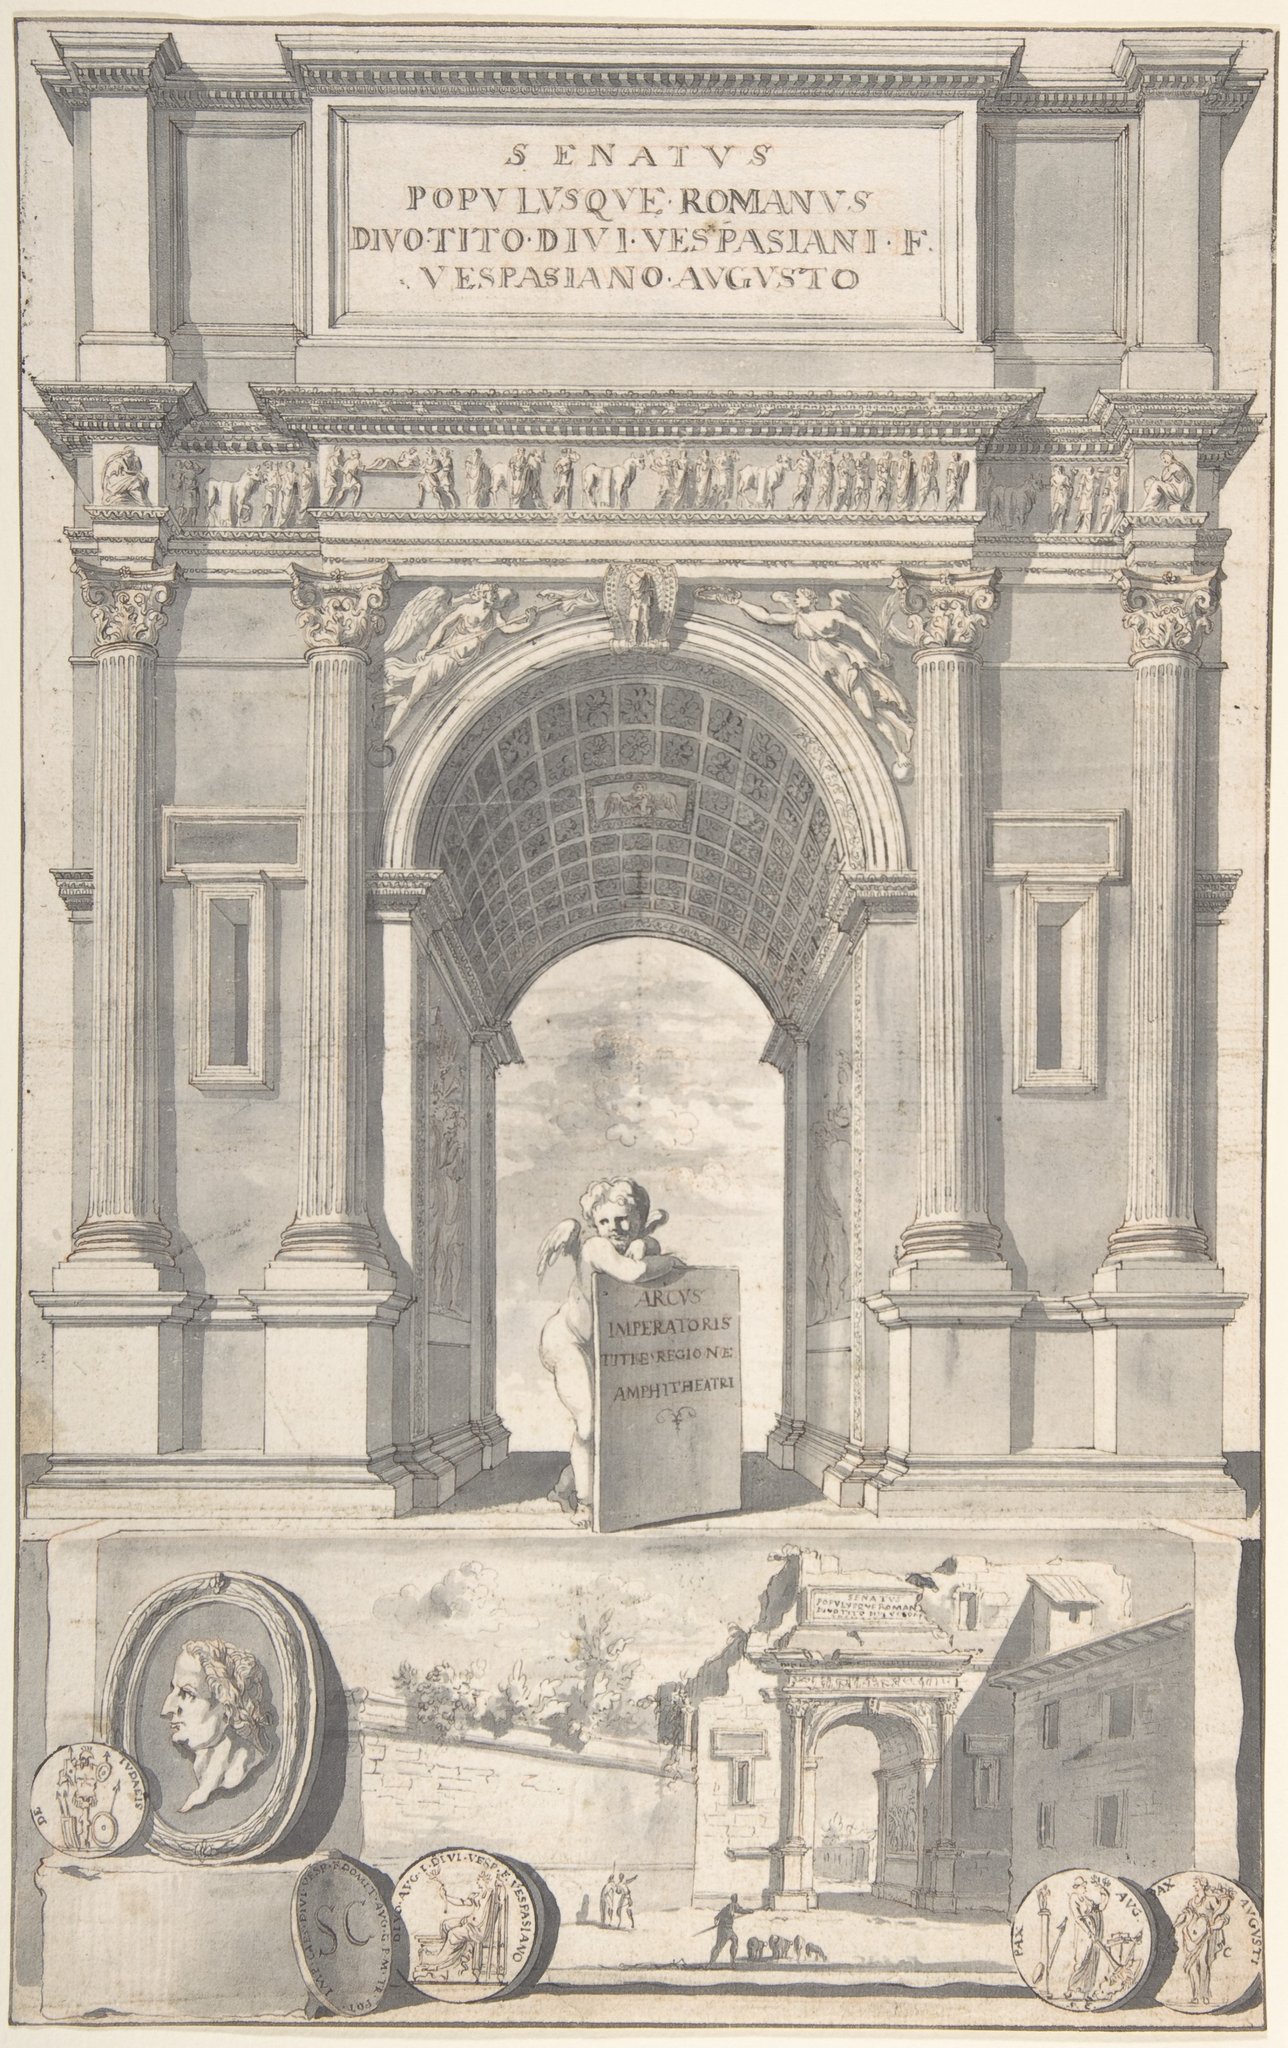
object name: drawing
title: A Reconstruction of the Arch of Titus (above) and a View of the Ruins (below)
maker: jan goeree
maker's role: artist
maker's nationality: dutch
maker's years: 1670-1731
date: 1704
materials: chalk, ink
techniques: brush, incising, pen, wash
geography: italy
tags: architecture,arches,ruins